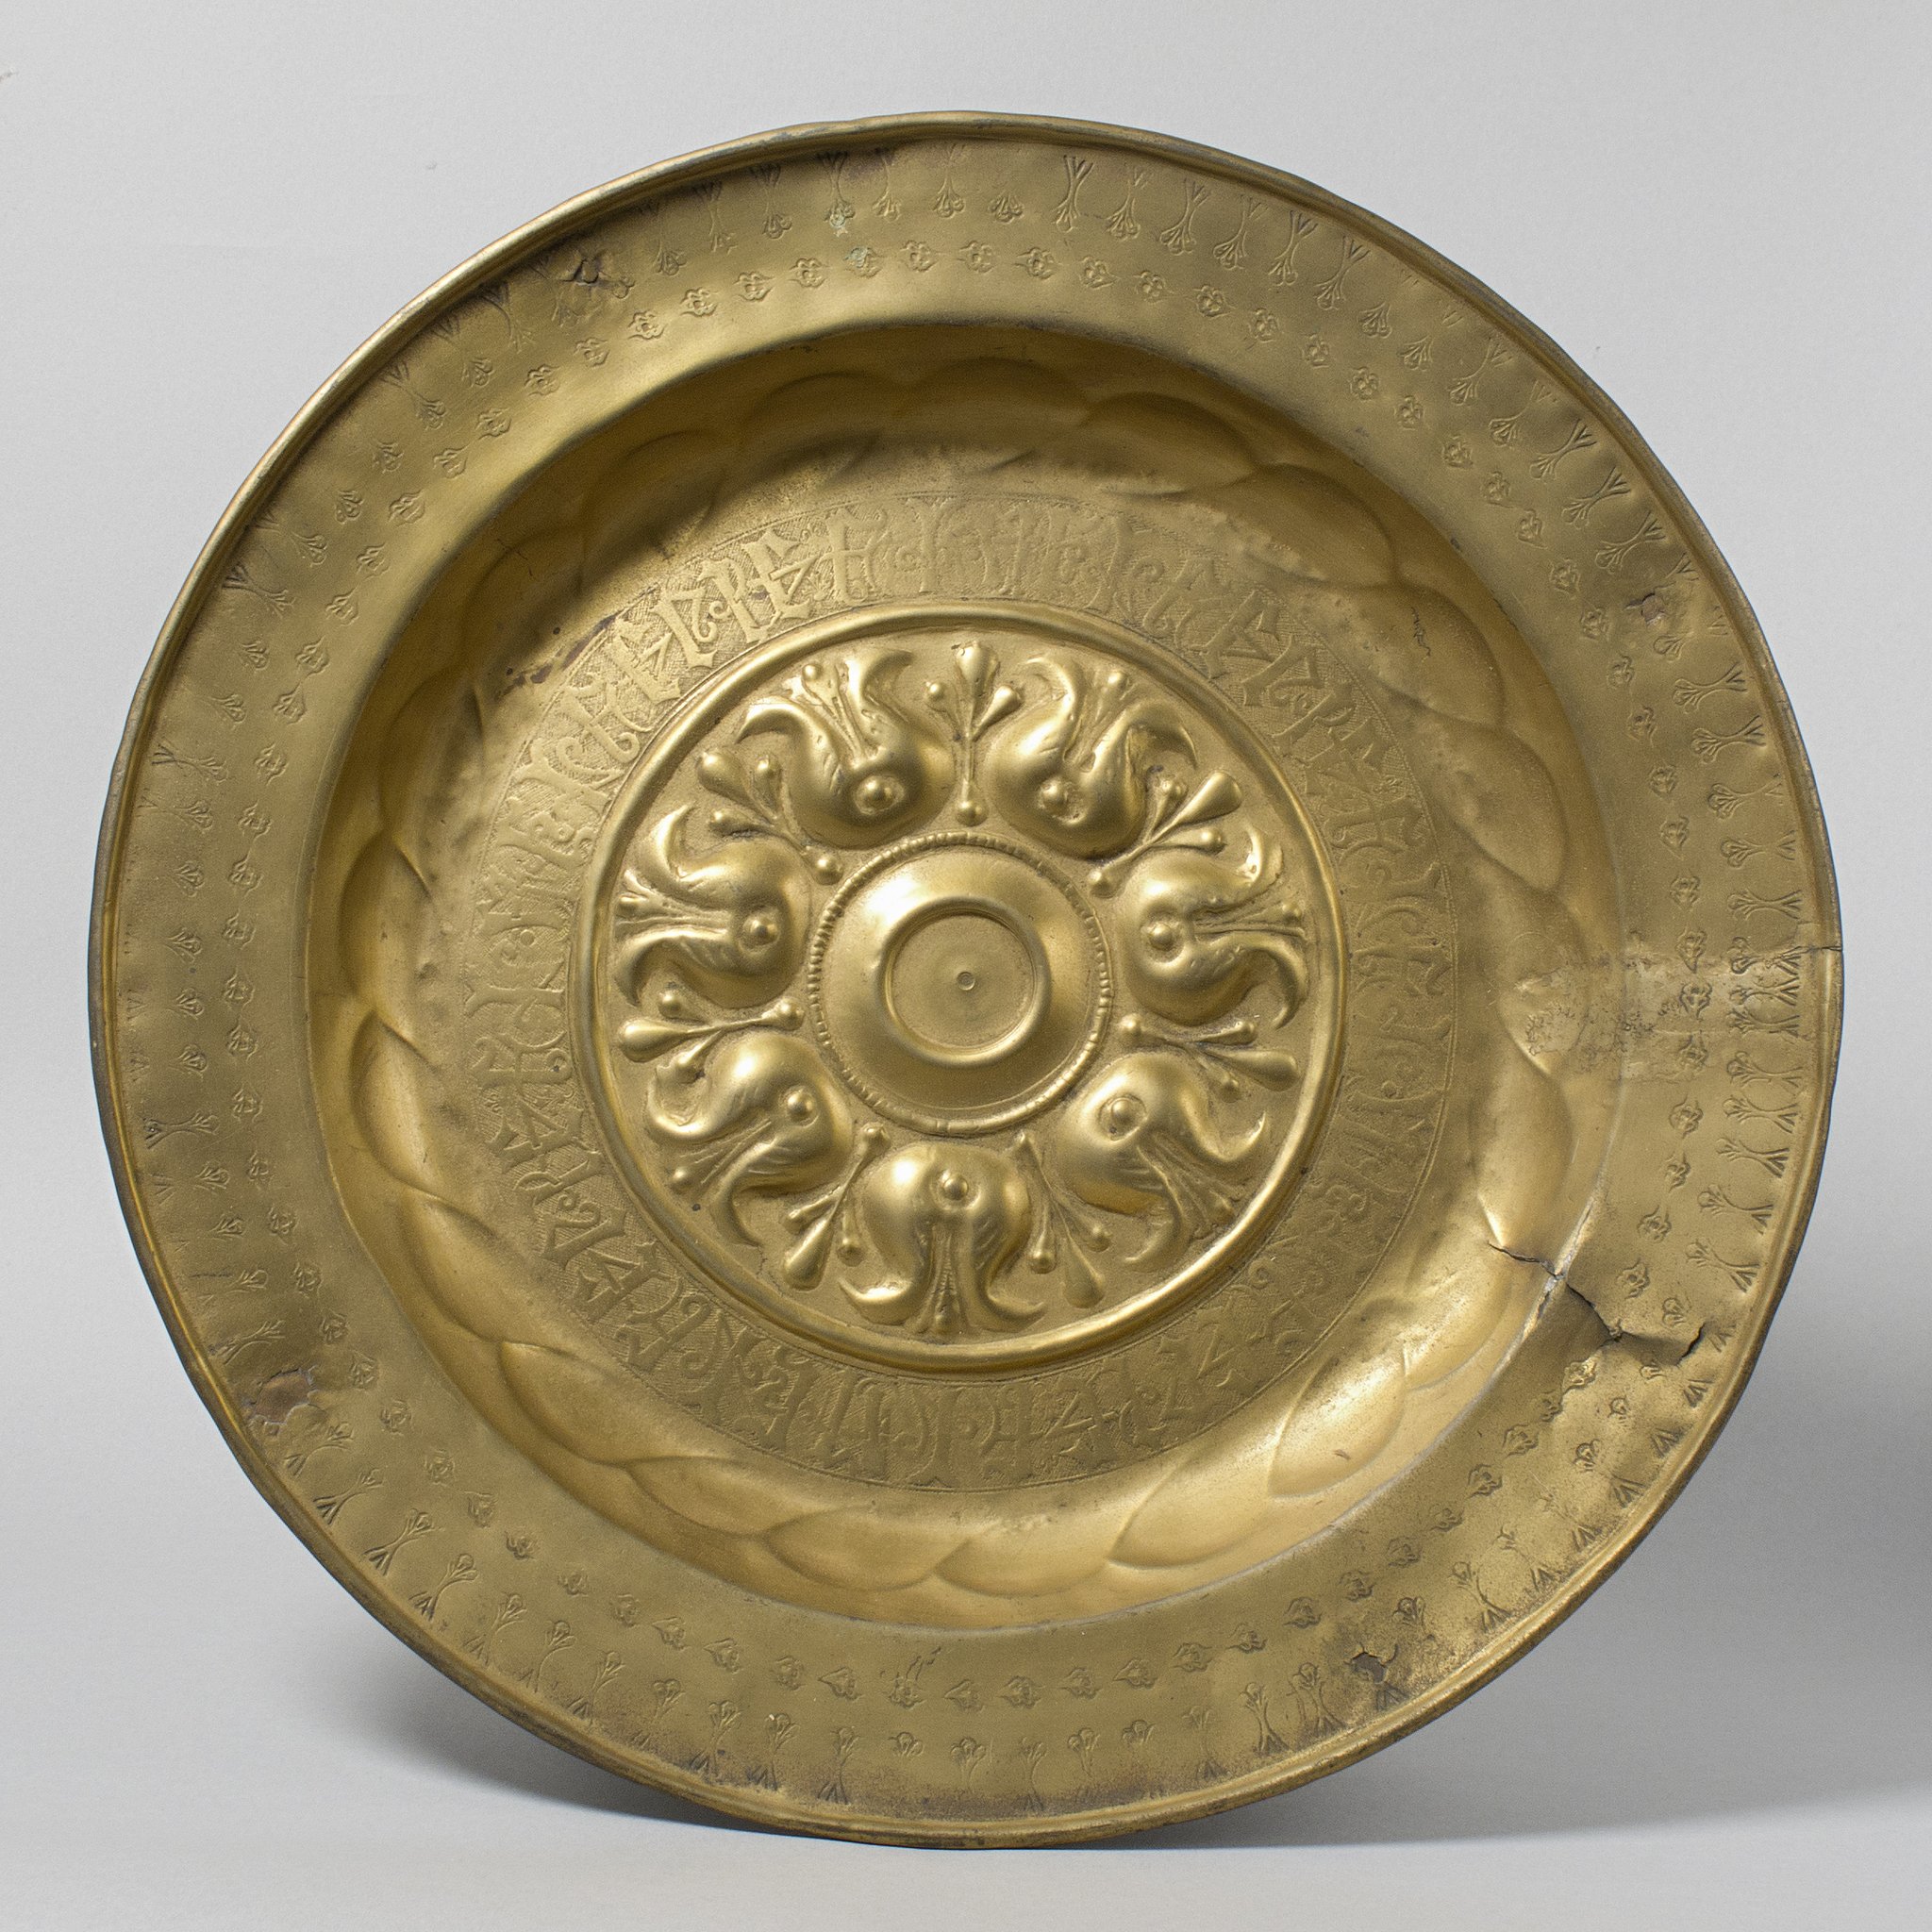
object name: dish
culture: german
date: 1501-1533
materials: brass